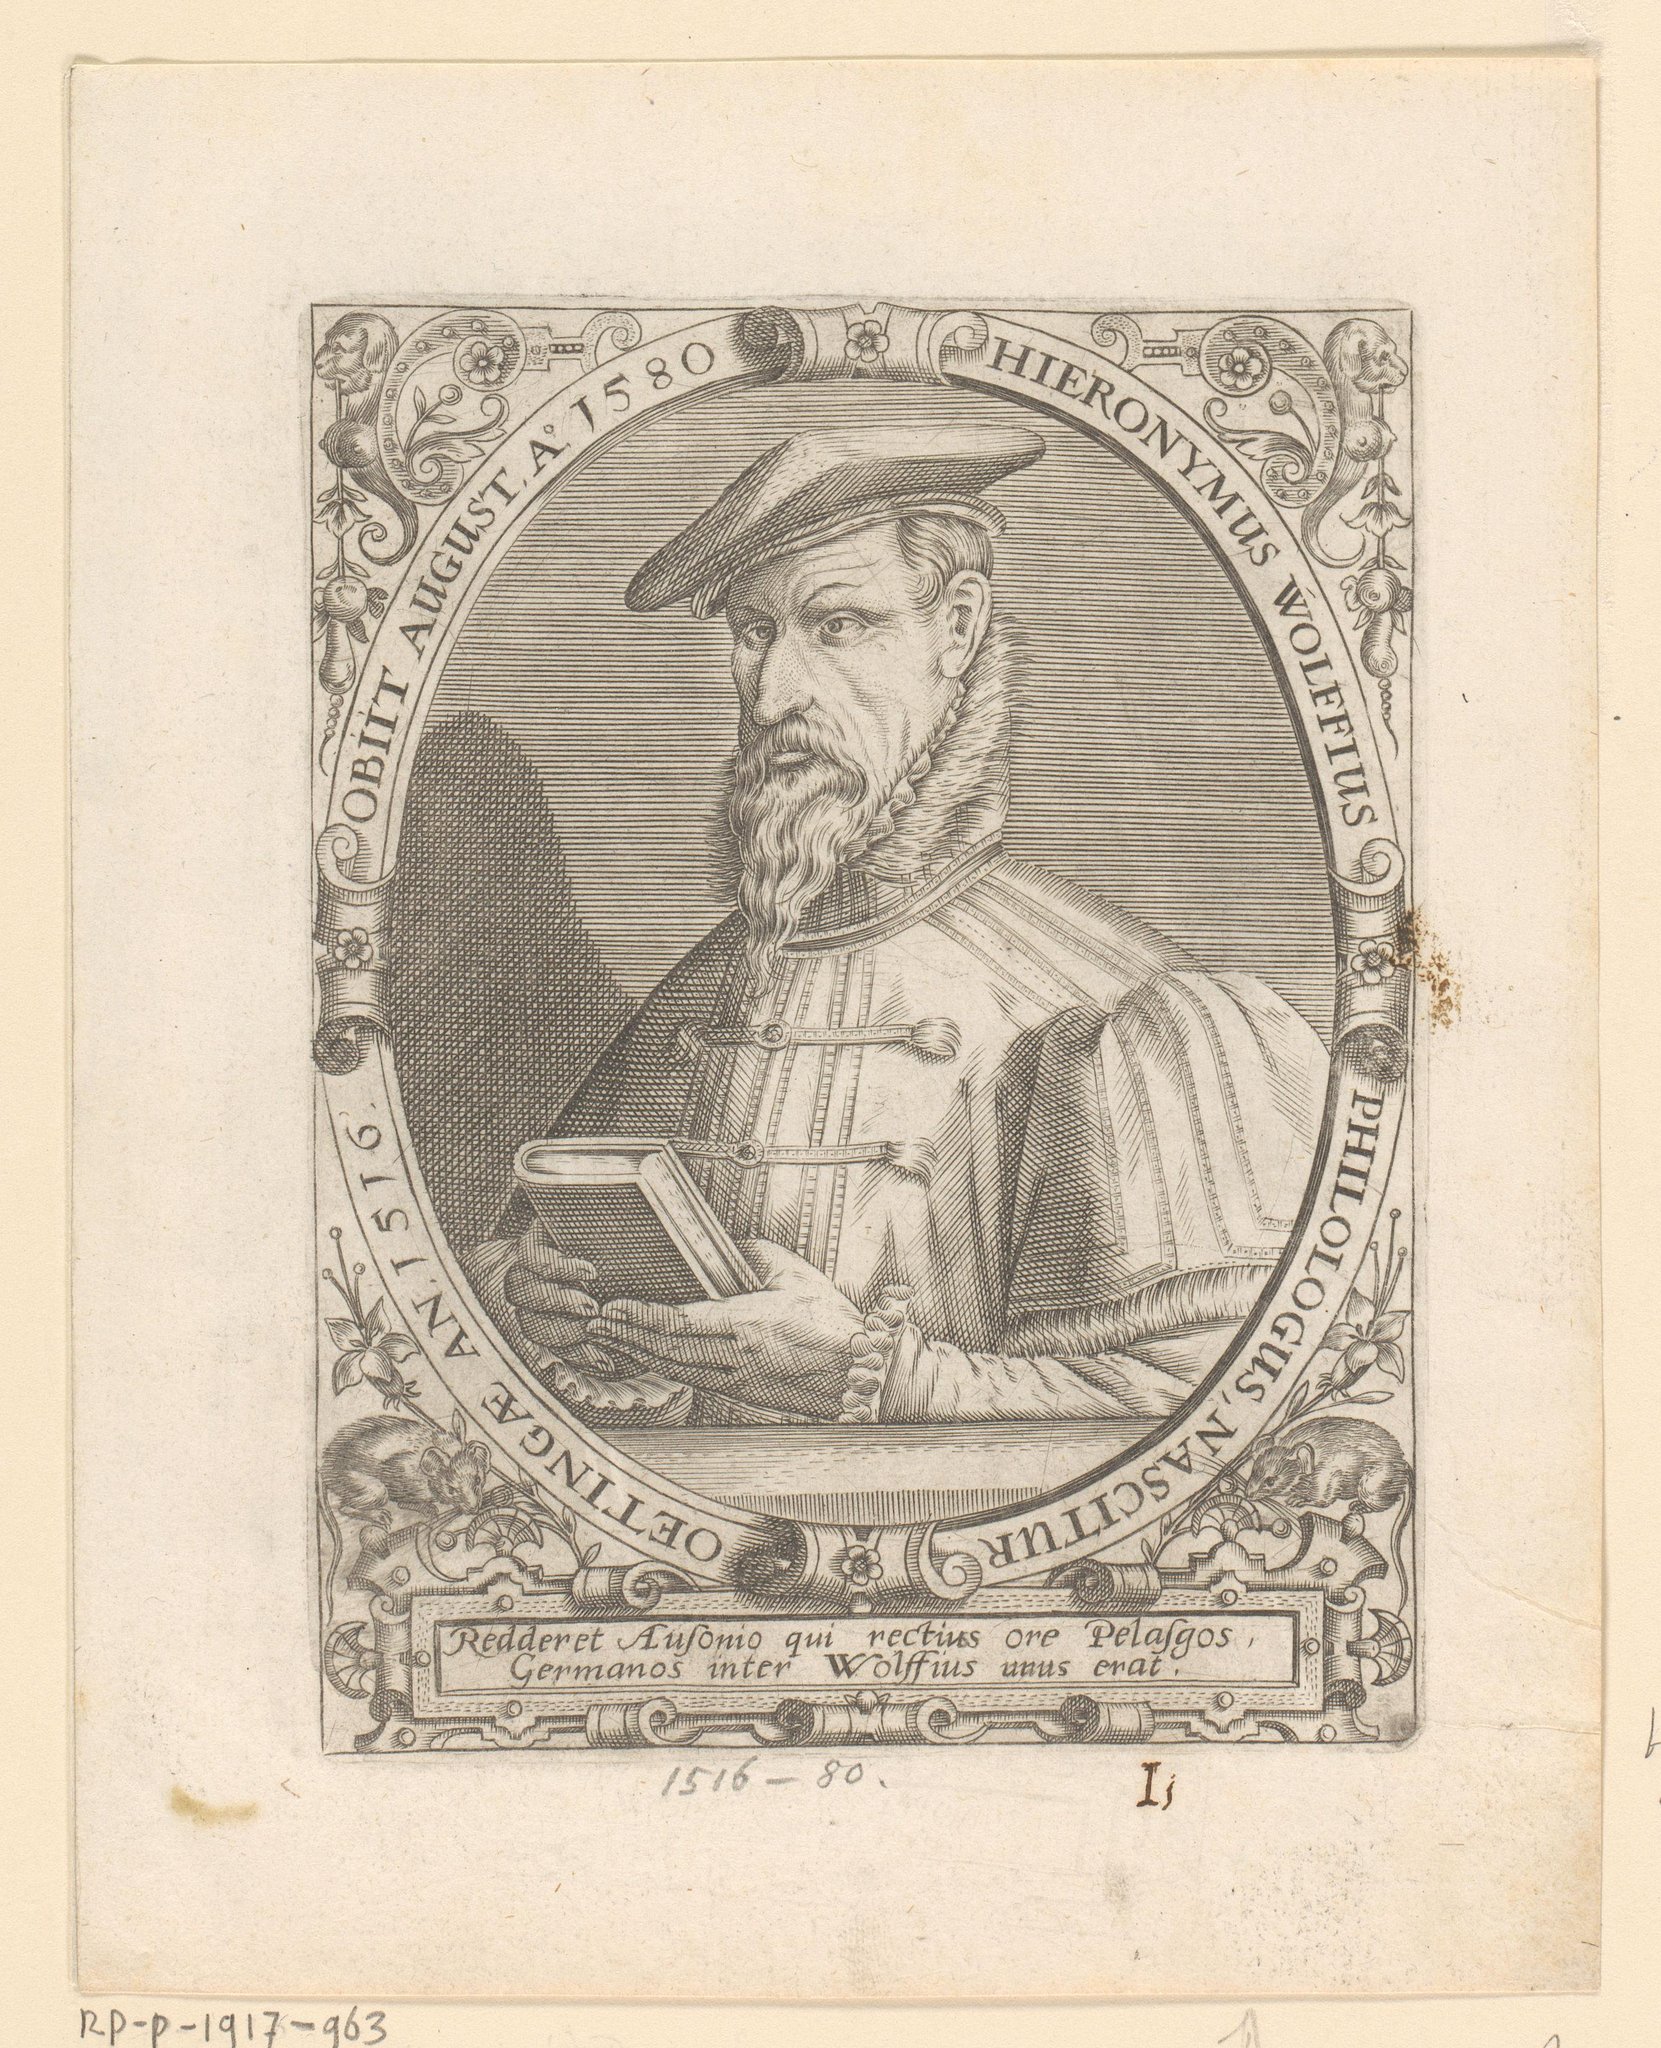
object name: book illustration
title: Hieronymus Wolffius philologus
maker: jean jacques boissard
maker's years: 1528-1598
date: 1598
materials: paper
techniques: engraving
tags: historical persons, public library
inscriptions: collector's mark: Lugt 2228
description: Prent gebruikt in: Boissard, Jean Jacques. Icones quinquaginta virorum illustrium doctrina & eruditione praestantium ad vivum effictae. 4 dln. Frankfurt am Main: s.n., 1597-1599. Mogelijk ook gebruikt in latere edities. Latere staat van prent verschenen in: Boissard, Jean Jacques. Bibliotheca chalcographica. 8 dln. Frankfurt am Main: Johannes Ammon, 1650-1652. Ook gebruikt in latere edities.